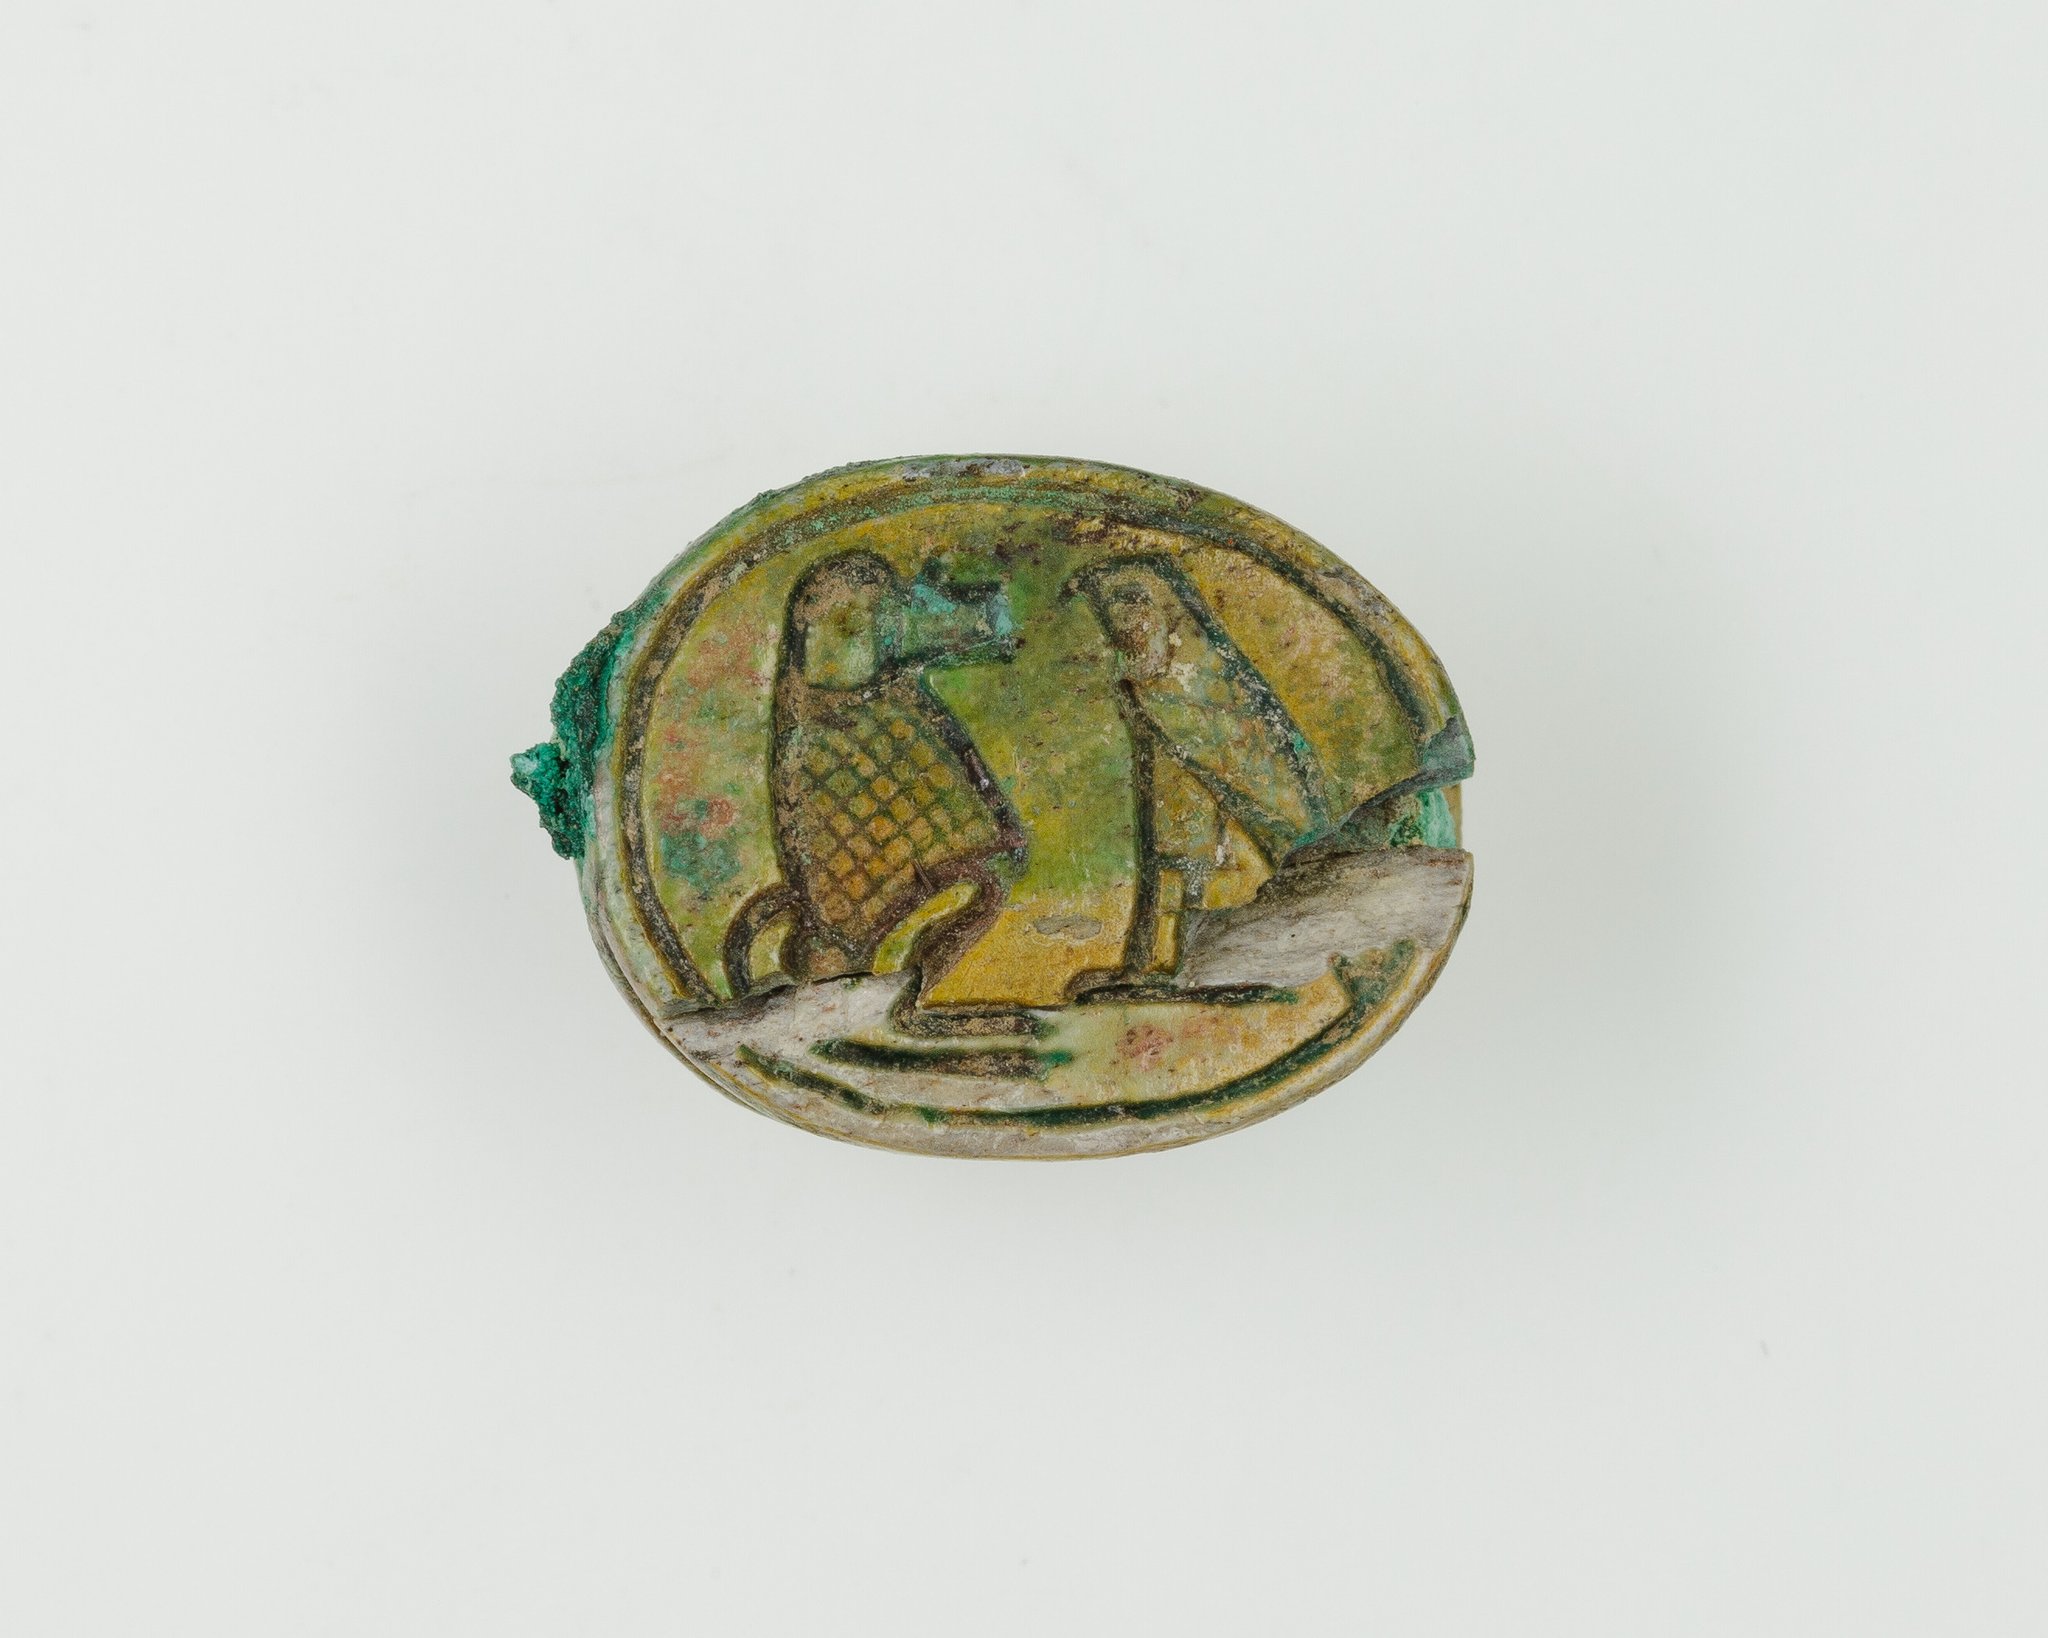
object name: scarab, baboon, falcon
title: Scarab with device of baboon and falcon on base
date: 1550-1458 BCE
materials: stone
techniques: glazing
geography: egypt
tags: falcons,baboons